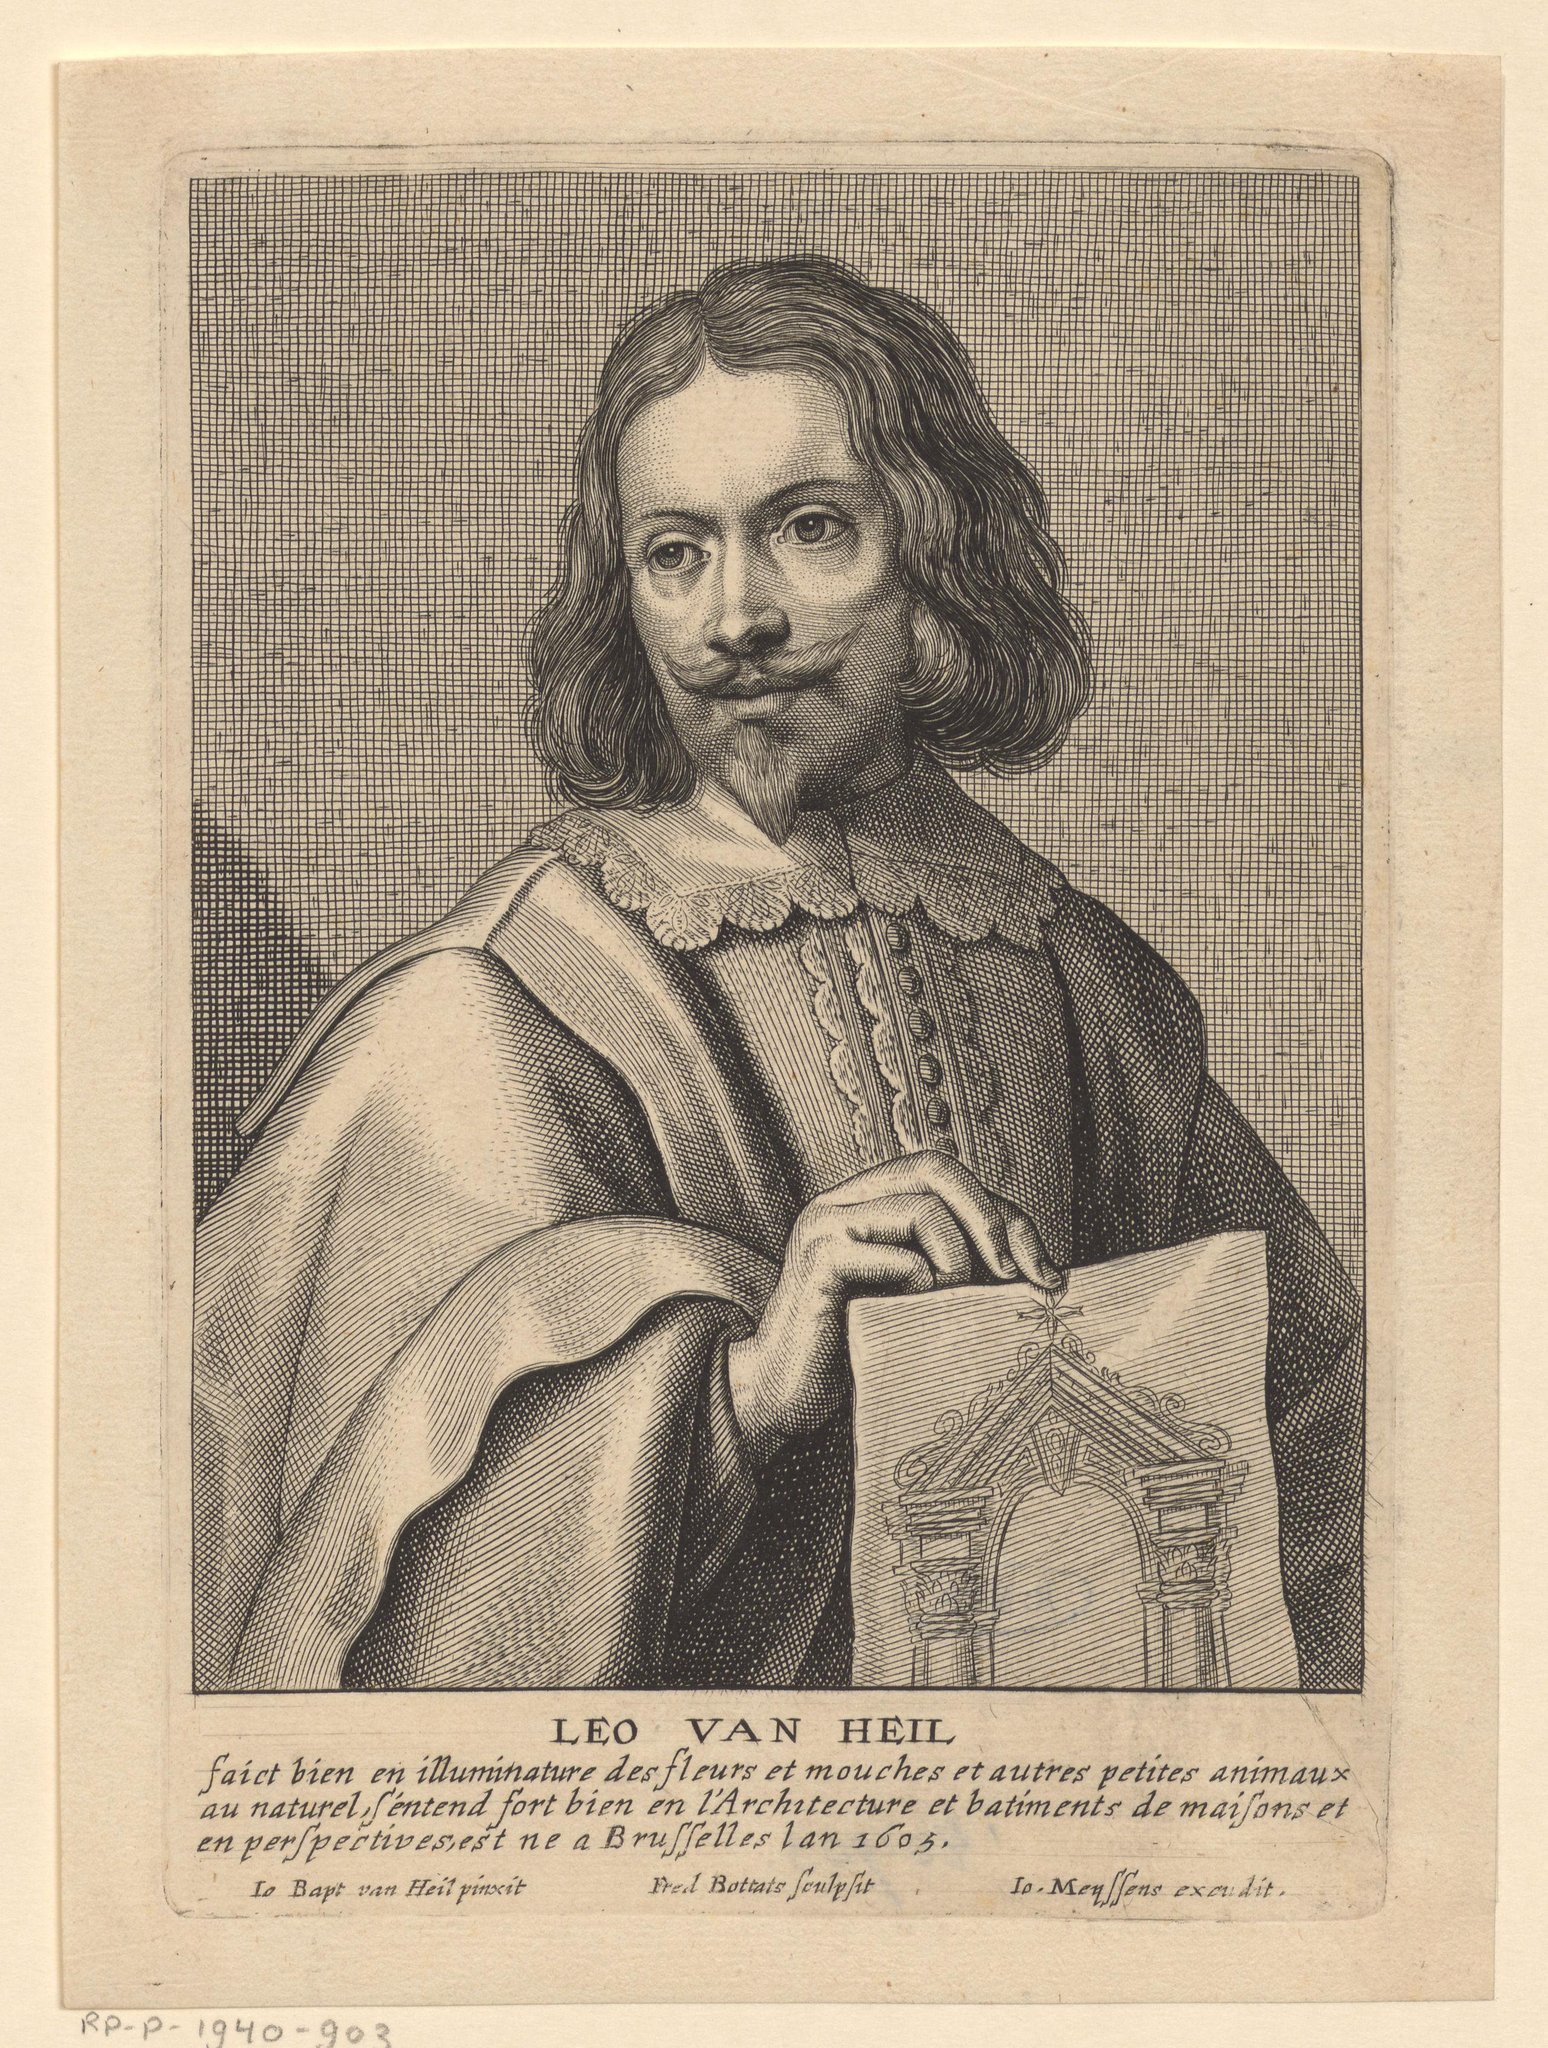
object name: print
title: Portret van Leo van Heil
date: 1649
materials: paper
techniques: engraving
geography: antwerp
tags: leo van heil, historical persons, portrait, self-portrait of painter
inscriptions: collector's mark: Lugt 2760, collector's mark: Lugt 2228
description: Prent ook gebruikt in: Bie, Cornelis de. Het gulden cabinet vande edele vry schilder-const (...). Antwerpen: Juliaen van Montfort, 1662.